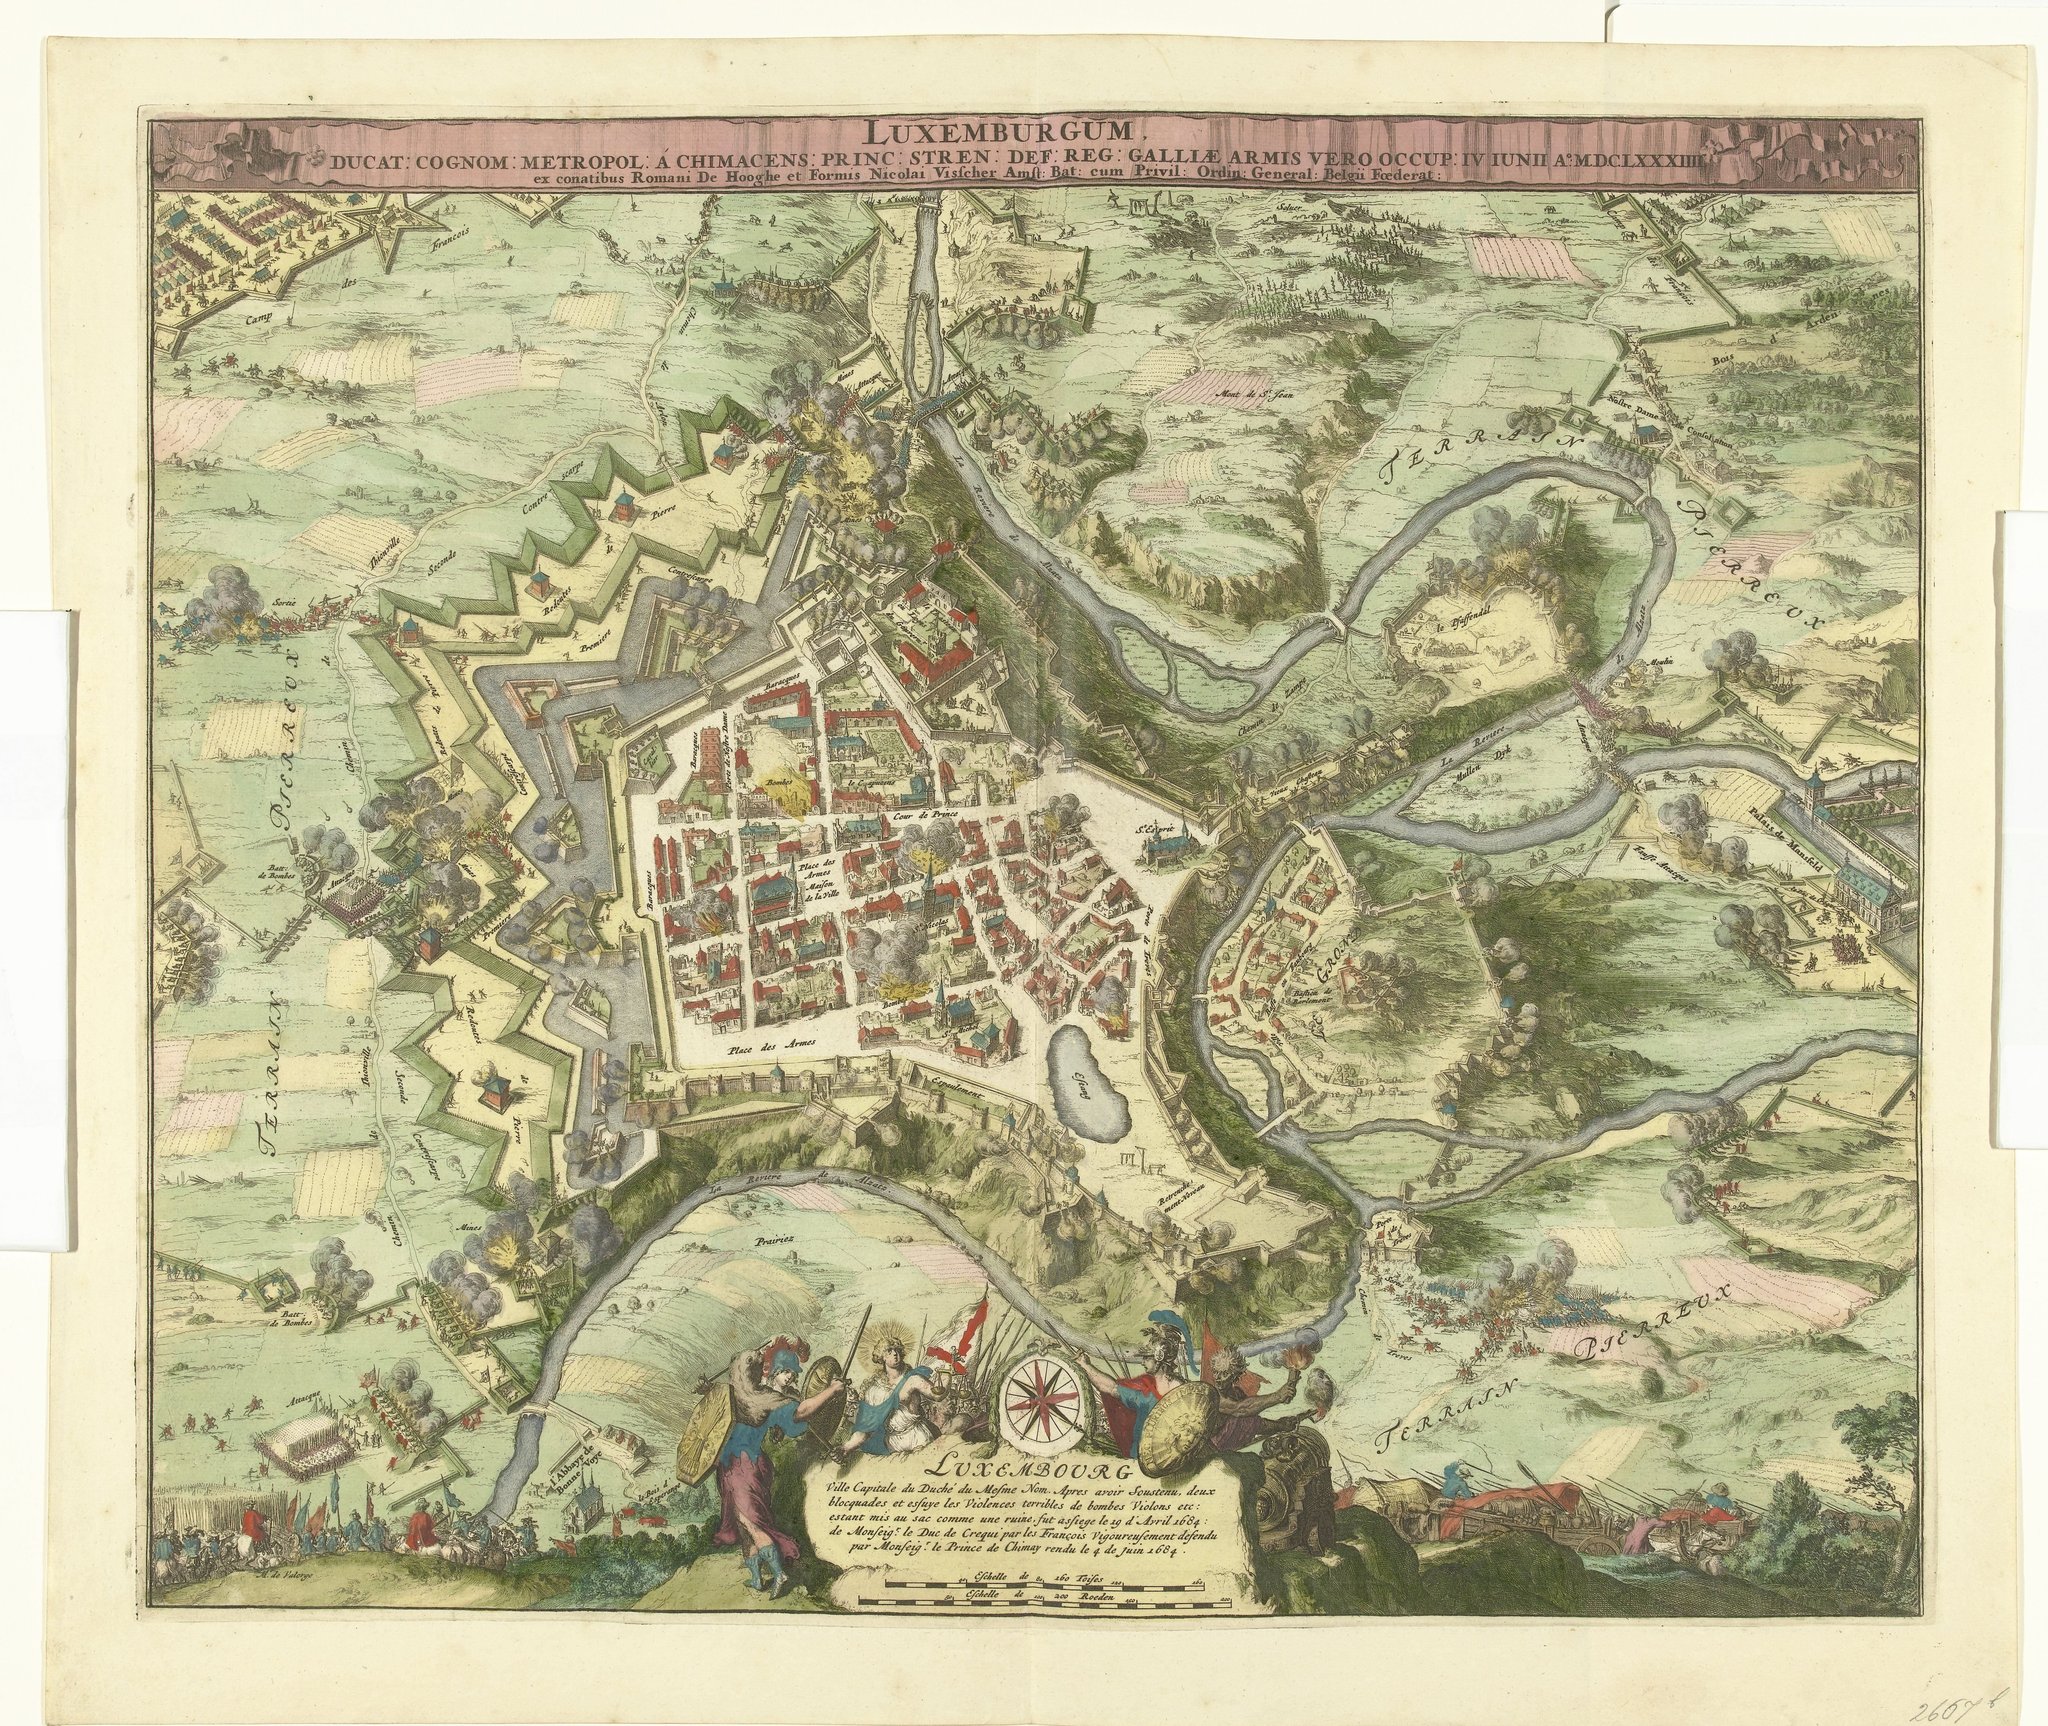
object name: print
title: Bombardement van Luxemburg door de maarschalk de Créquy, 1684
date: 1684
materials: paper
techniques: etching, hand coloring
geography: northern netherlands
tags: maps of separate countries or regions, siege, position war, maps of cities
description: Belegering en bombardement van de stad Luxemburg door het Franse leger onder bevel van maarschalk de Créquy, 4 juni 1684. Plan van de stad en omgeving, op de voorgrond een cartouche met Franse tekst en meerdere allegorische figuren.